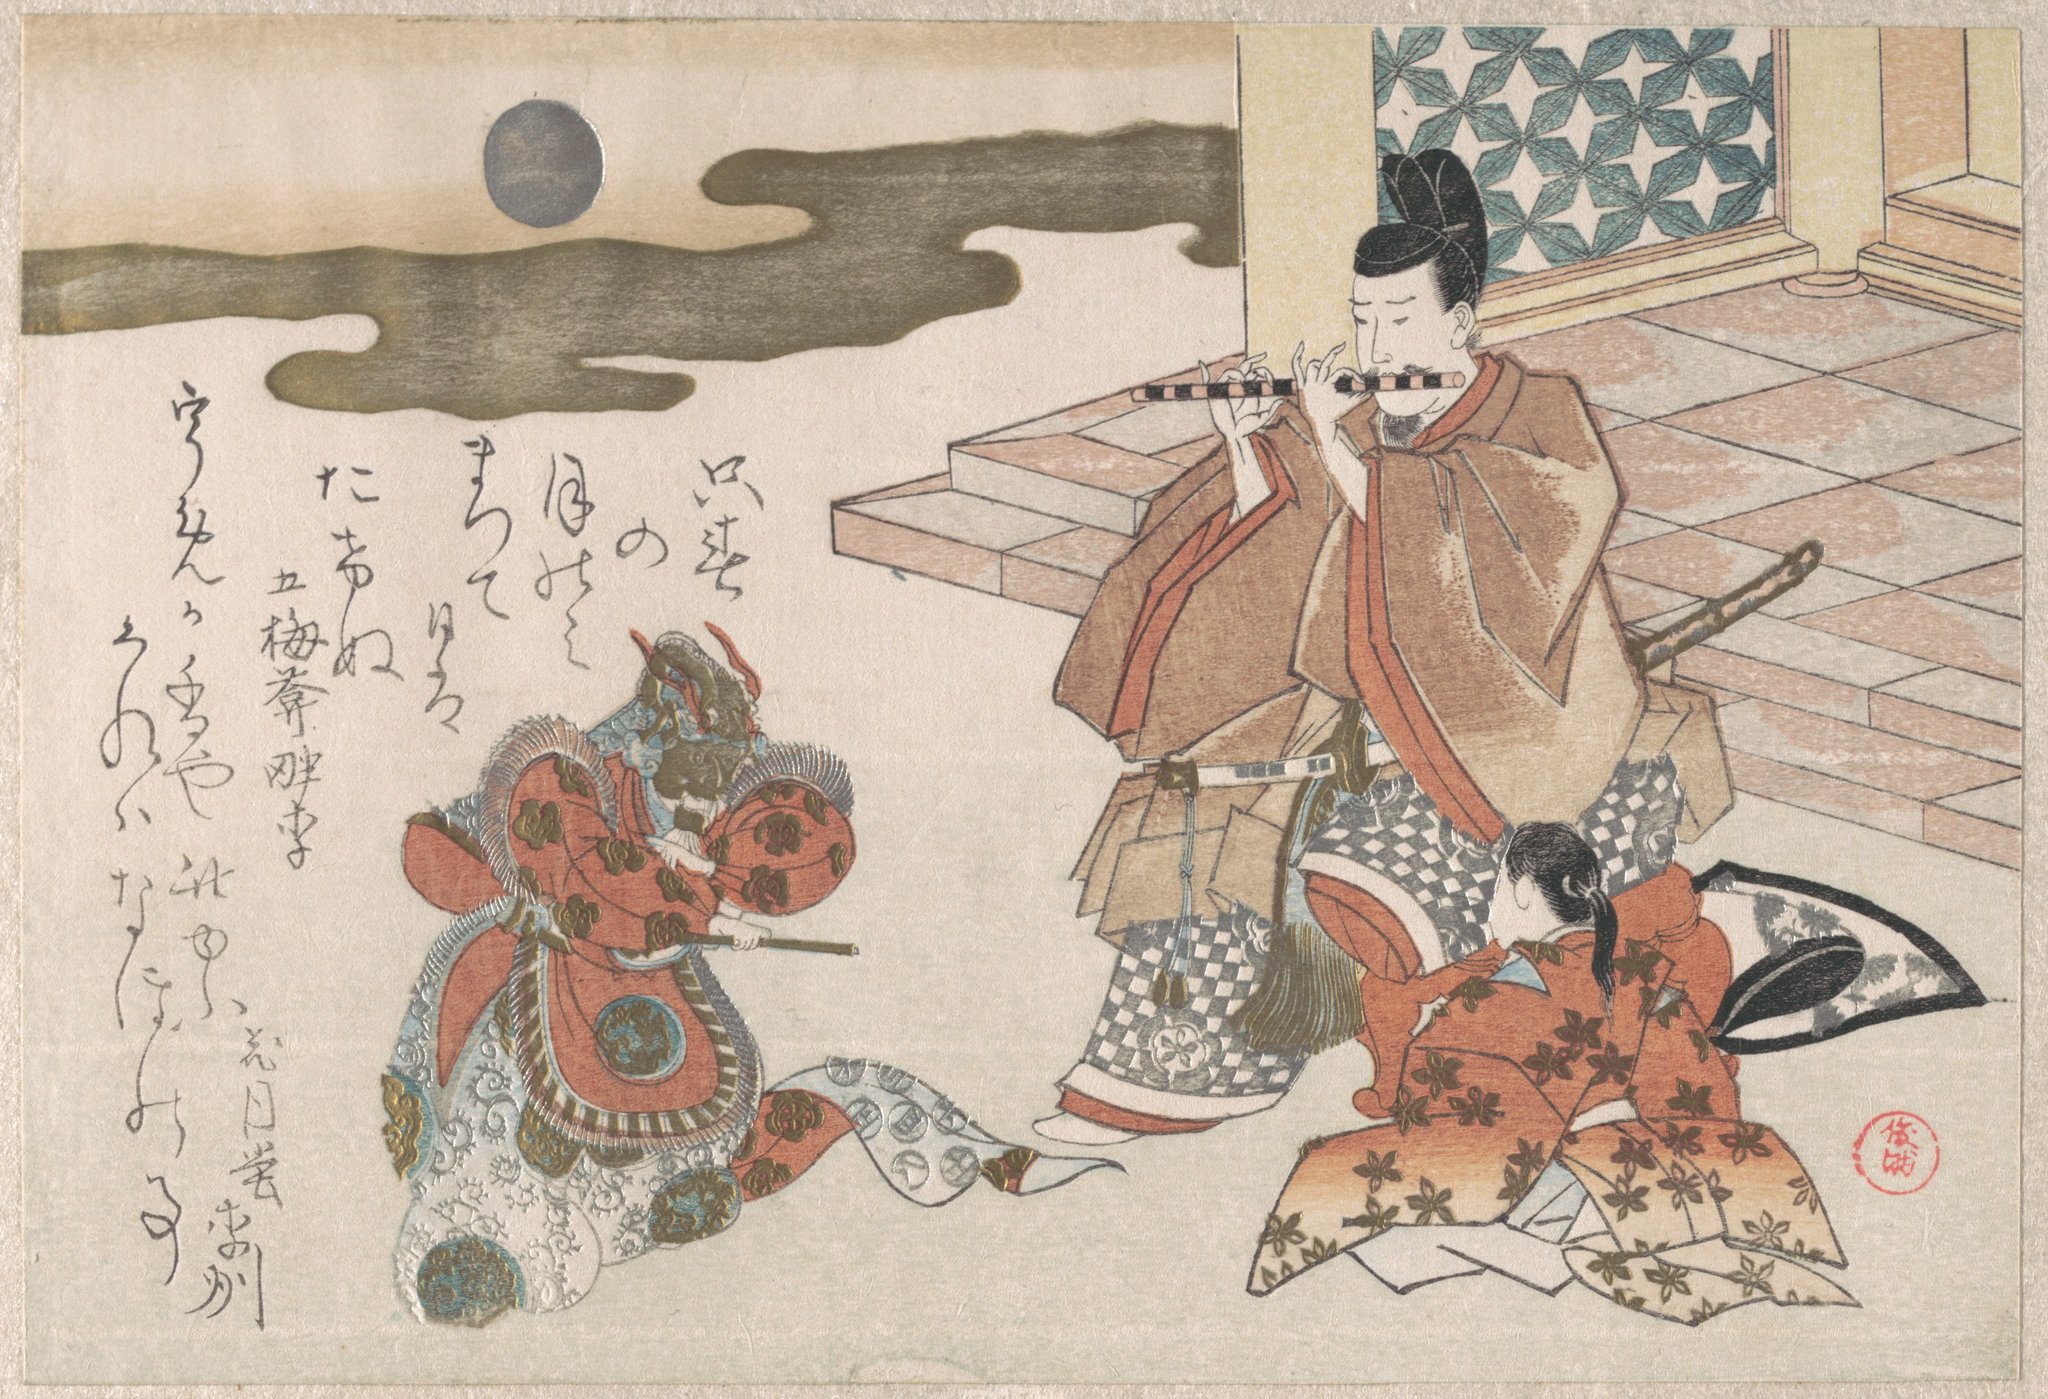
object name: print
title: Courtier Playing a Flute to Accompany a Bugaku Dance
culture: japanese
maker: kubo shunman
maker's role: artist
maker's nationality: japanese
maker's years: 1757-1820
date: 1810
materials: ink, paper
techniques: surimono, woodblock print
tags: girls,men,flutes